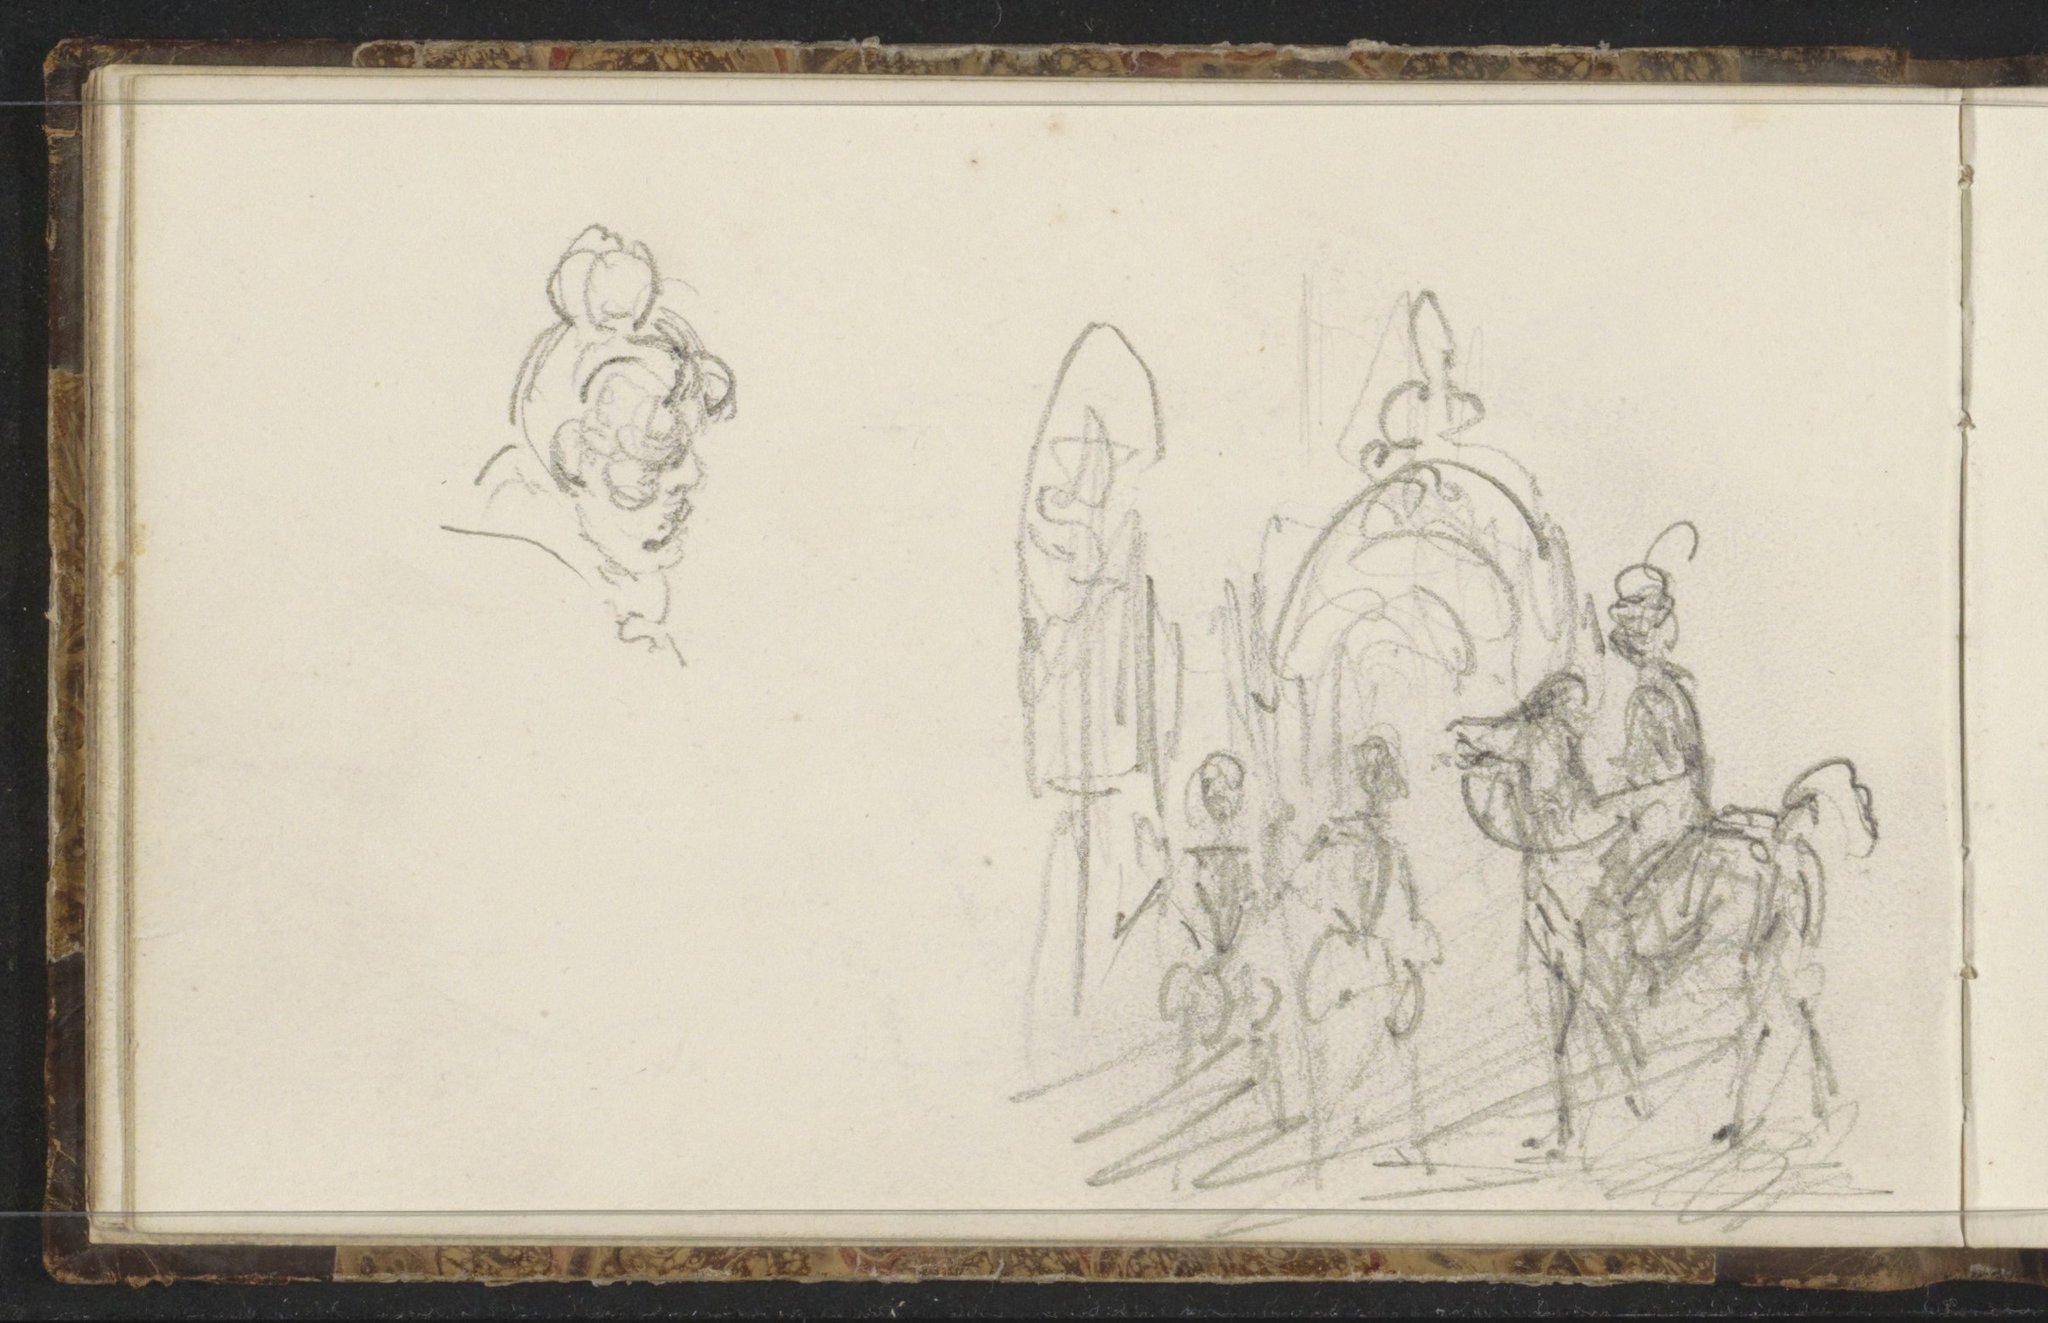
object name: sketchbook leaf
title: Ruiter en twee mannen bij een poort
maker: willem hendrik schmidt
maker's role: draughtsman, painter, print maker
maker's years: 1809-1849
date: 1819-1849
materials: paper, pencil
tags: riding a horse, ass, or mule; rider, horseman, gate, entrance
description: Tevens een studie van een vrouw met een muts. Blad 10 verso uit een schetsboek met 60 bladen.